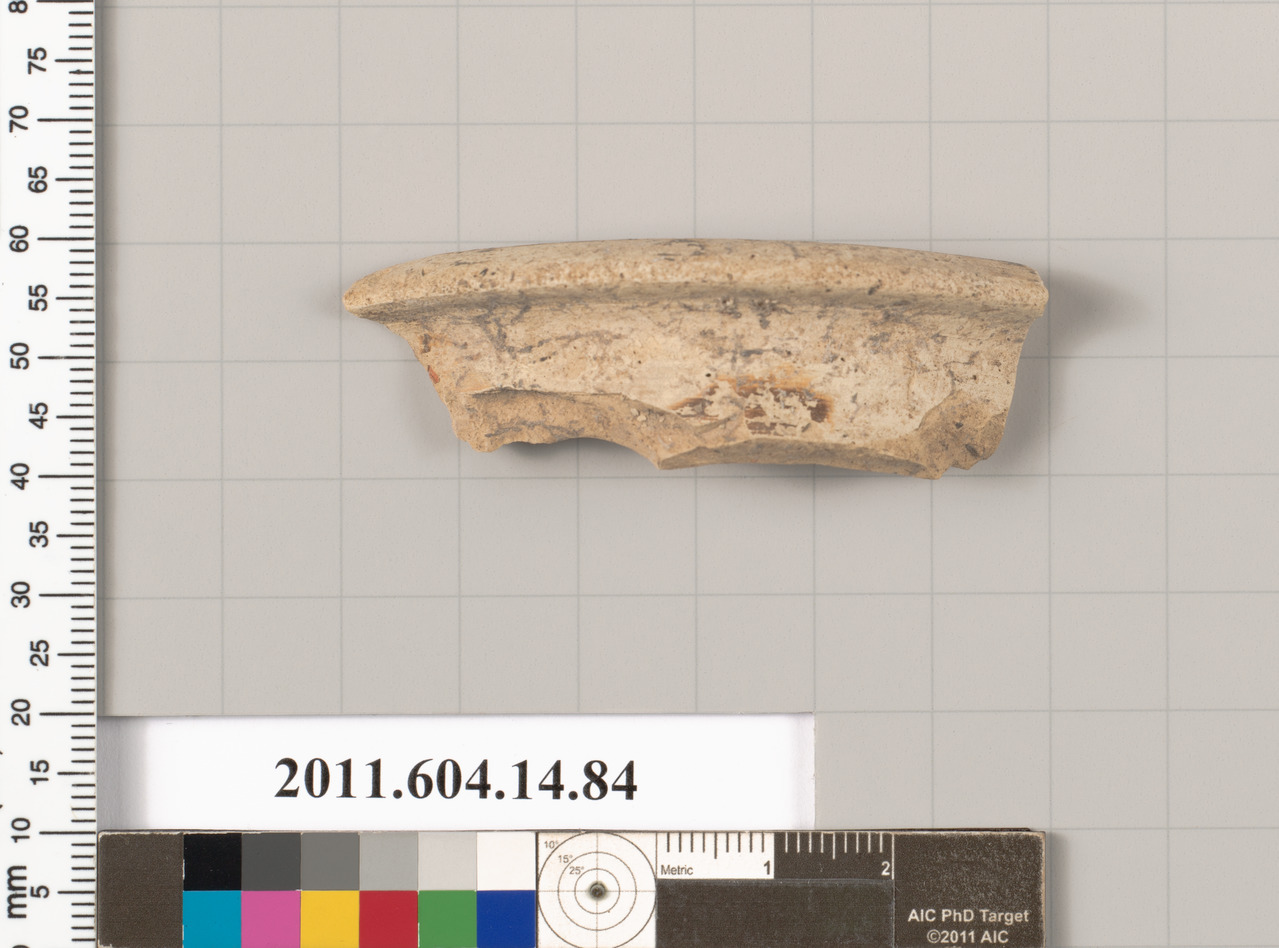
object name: vase fragment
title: Terracotta fragment of a vase?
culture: unknown fabric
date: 700-301 BCE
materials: terracotta